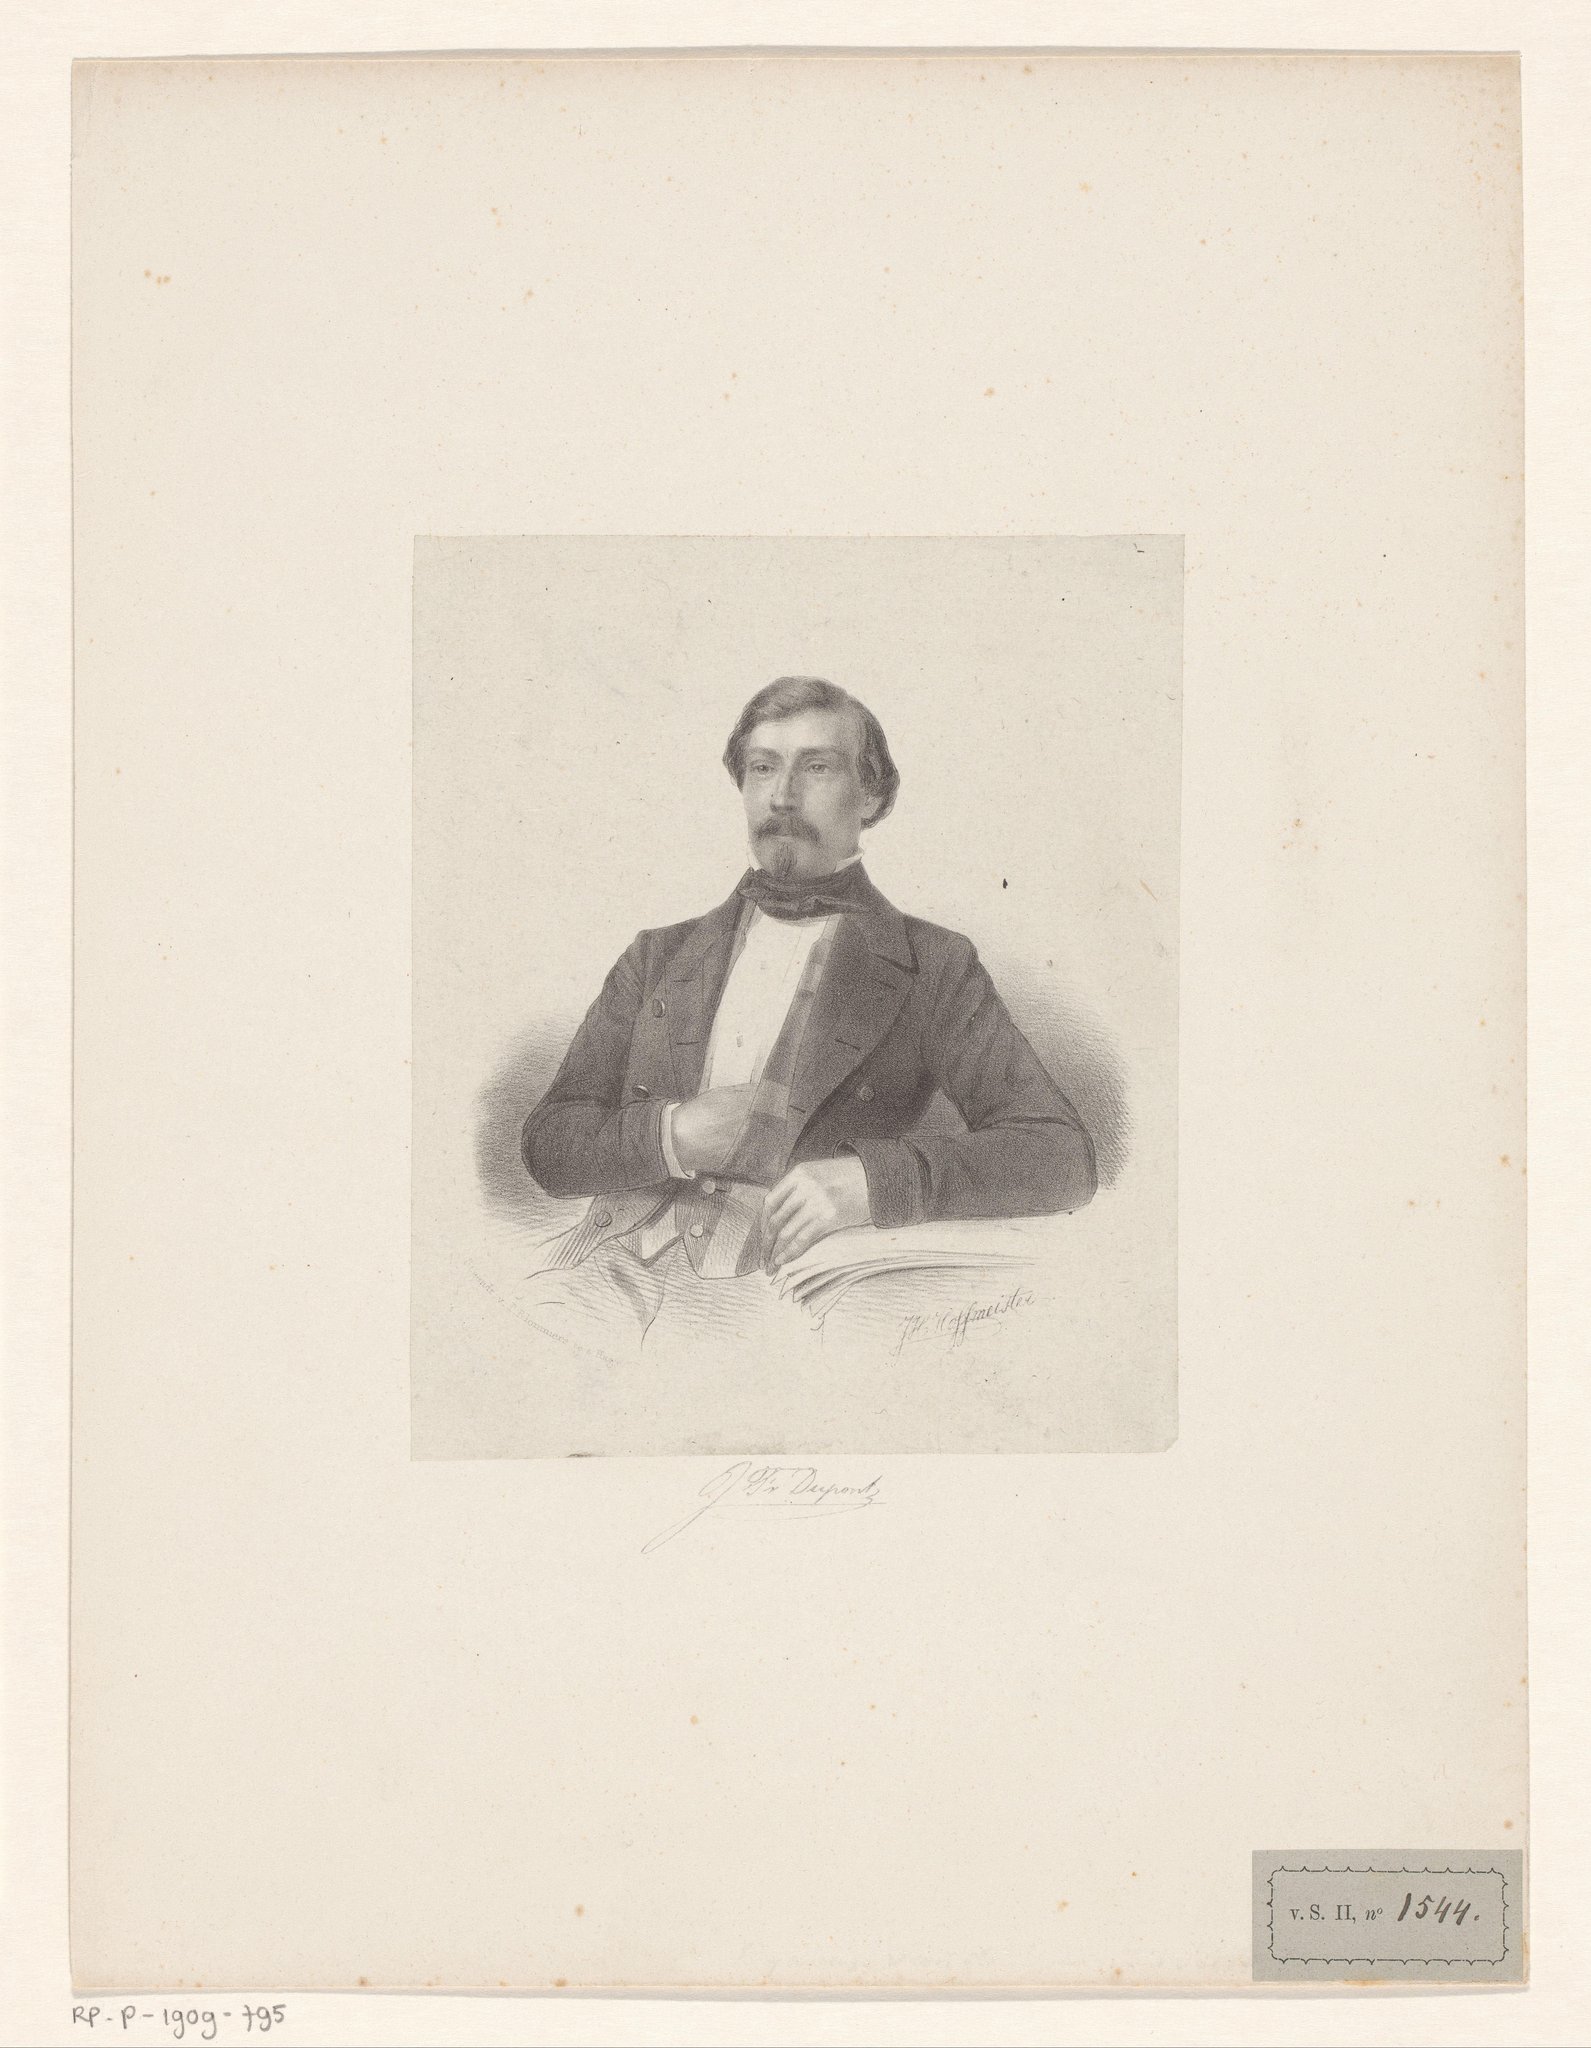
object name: print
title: Portret van Johannes Franciscus Dupont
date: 1843-1887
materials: paper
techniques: lithograph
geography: netherlands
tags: historical persons (+ (full) bust portrait)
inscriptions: collector's mark: Lugt 2228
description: Onder het portret de signatuur van de geportretteerde.